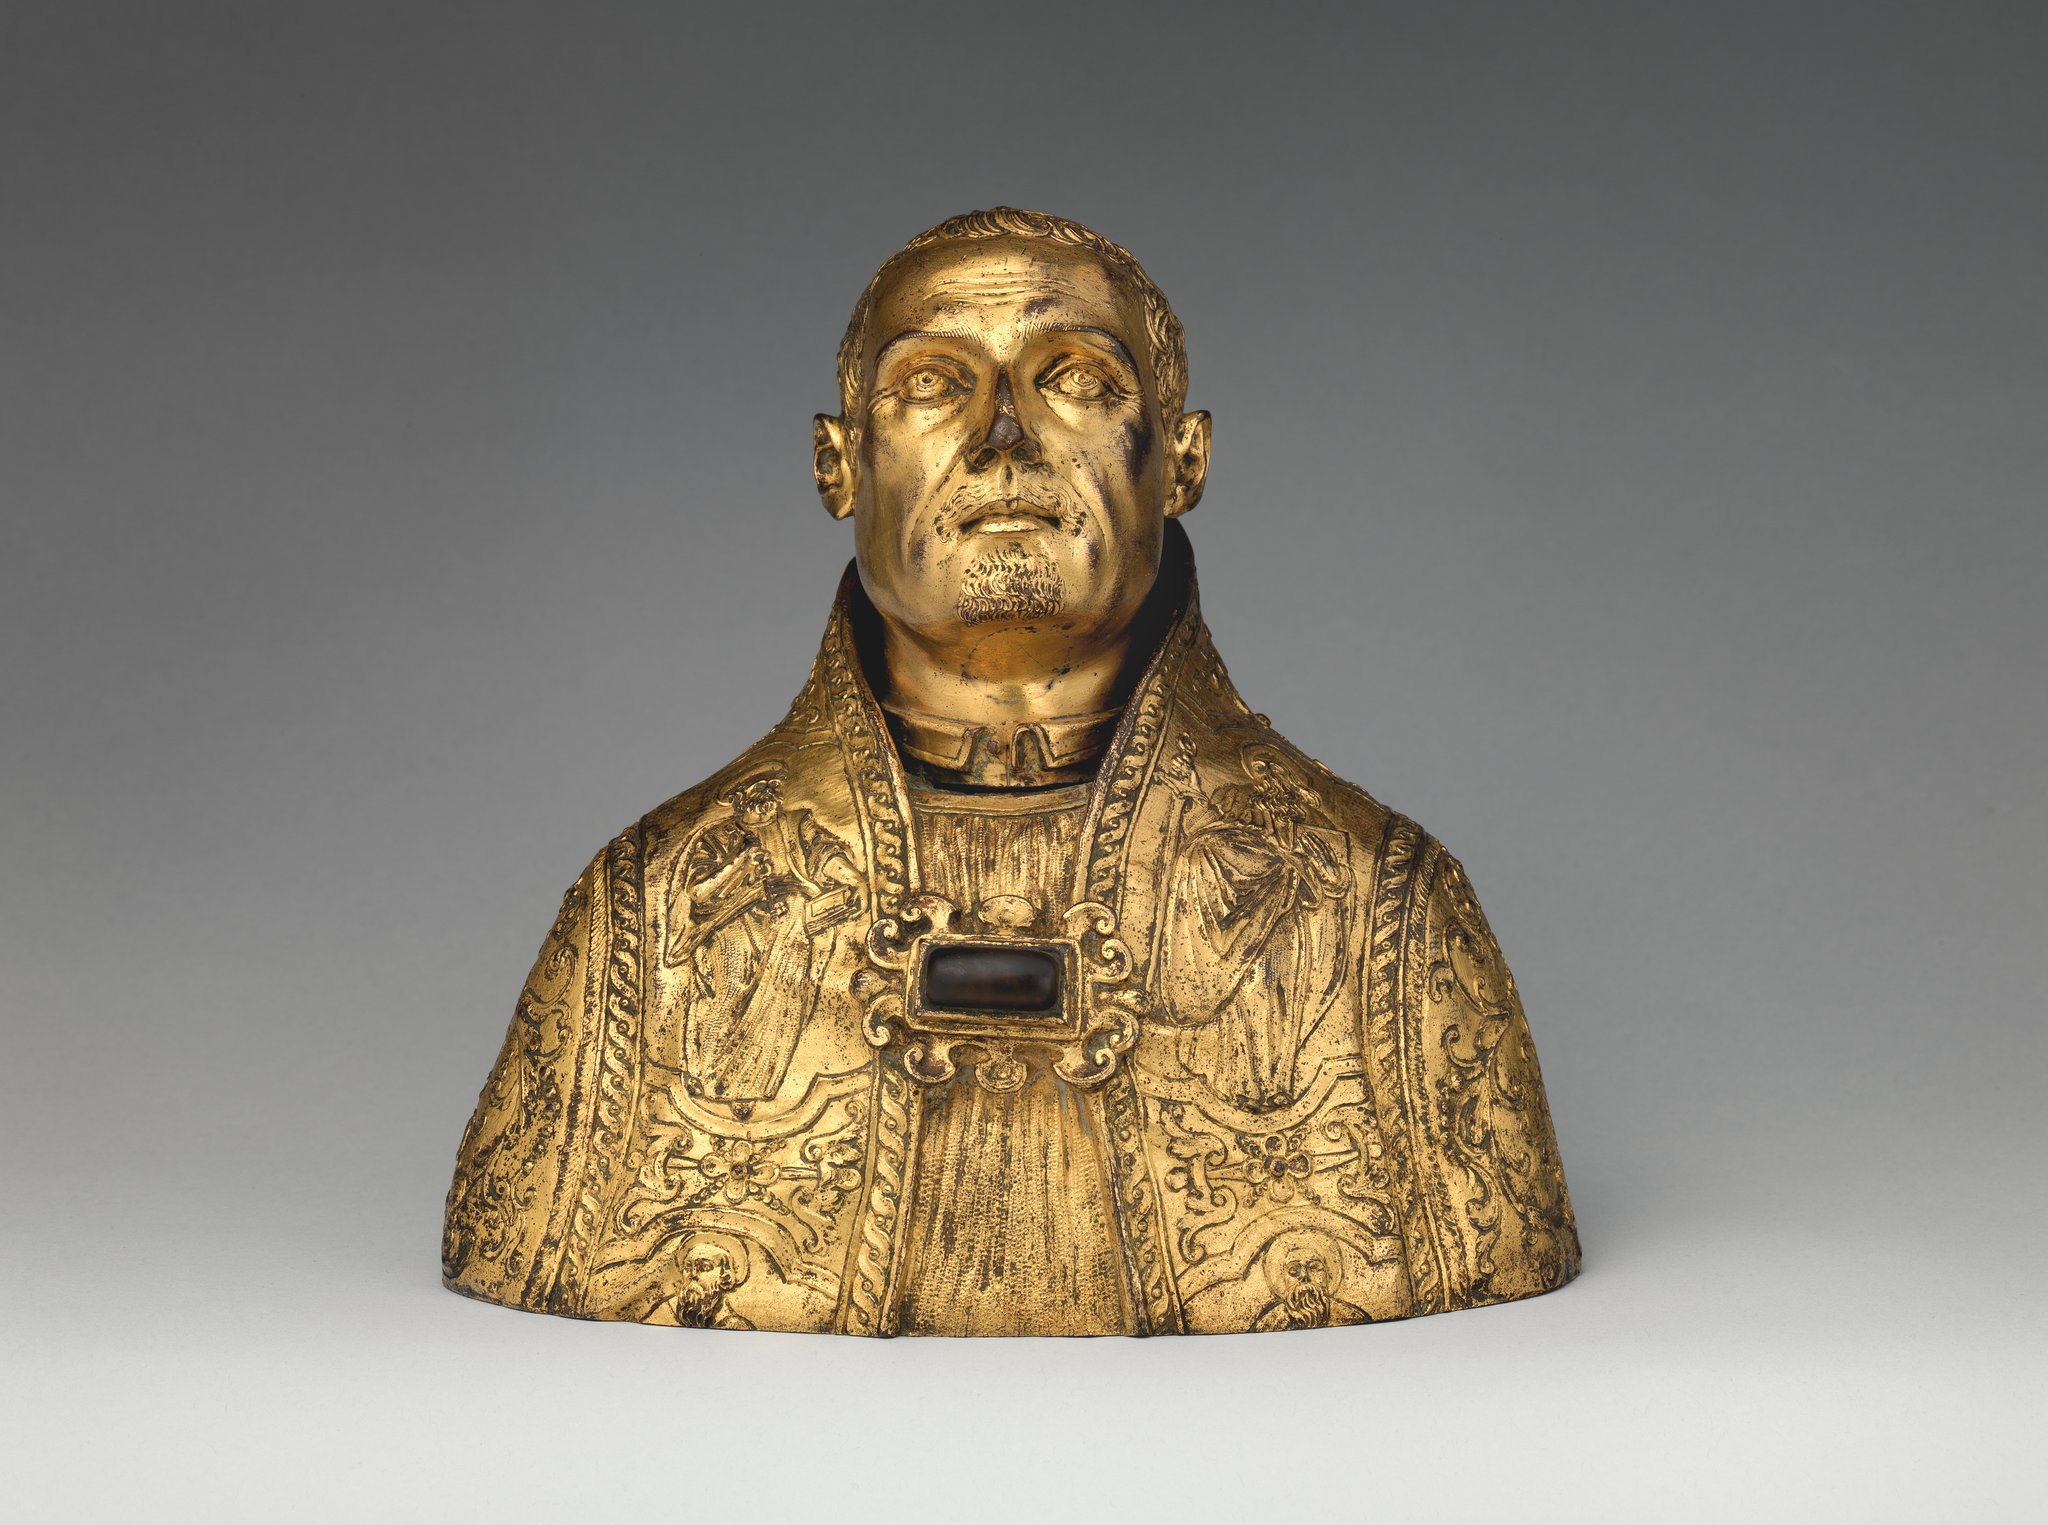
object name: bust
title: Reliquary bust of a bishop-saint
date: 1601-1633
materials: bronze, gilt, glass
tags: bishops,saints